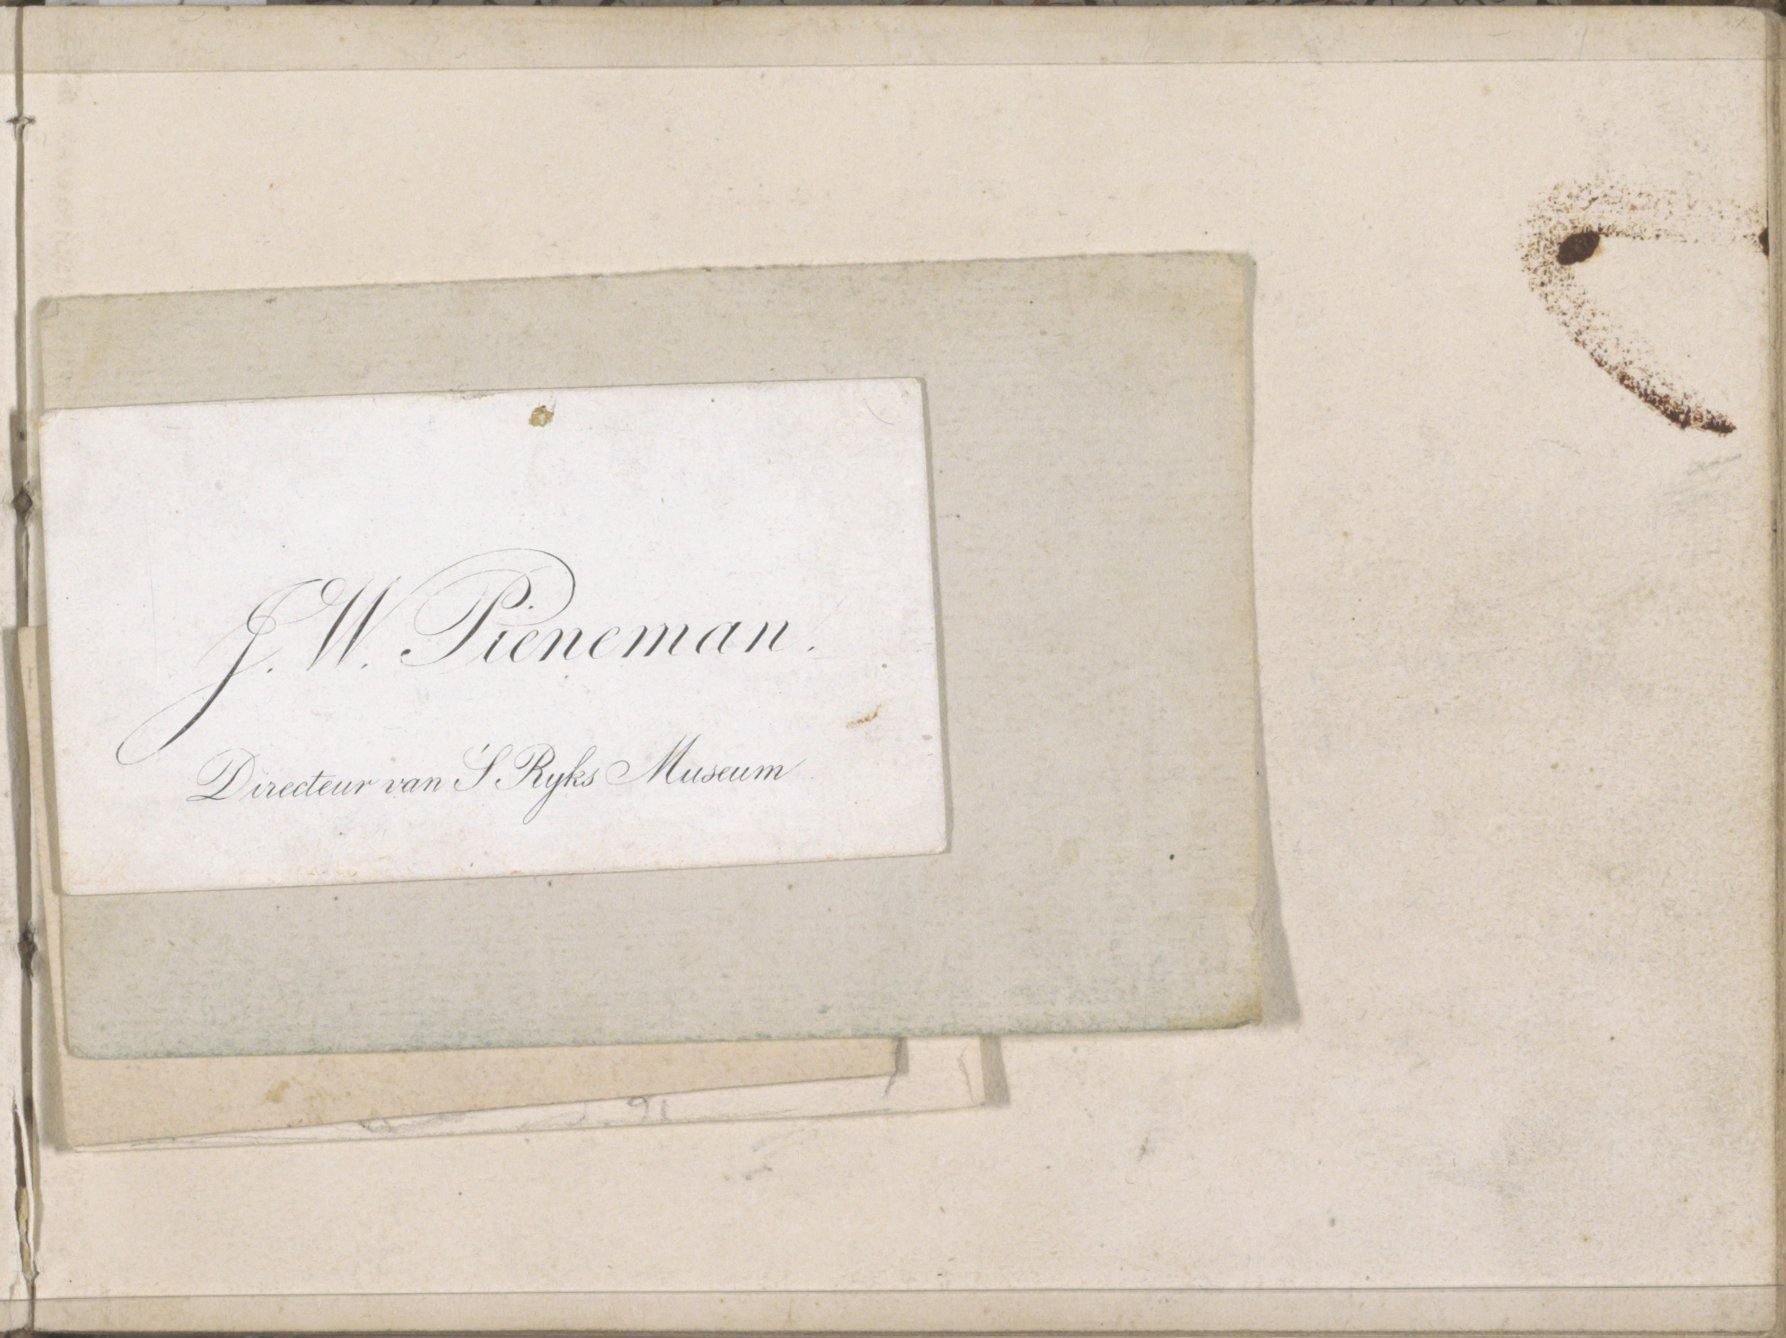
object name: sketchbook leaf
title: Visitekaartje van J.W. Pieneman, directeur van het Rijksmuseum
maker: maria vos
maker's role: draughtsman, painter, print maker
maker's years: 1824-1906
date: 1834-1906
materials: ink, paper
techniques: pen, printing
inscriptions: annotation: ‘Mejuffrouw/ Vos’, inscription: ‘J.W. Pieneman/ Directeur van 'S Rijks Museum’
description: Los visitekaartje tussen het voorste schutblad en pagina 1 van een schetsboek met 21 bladen.